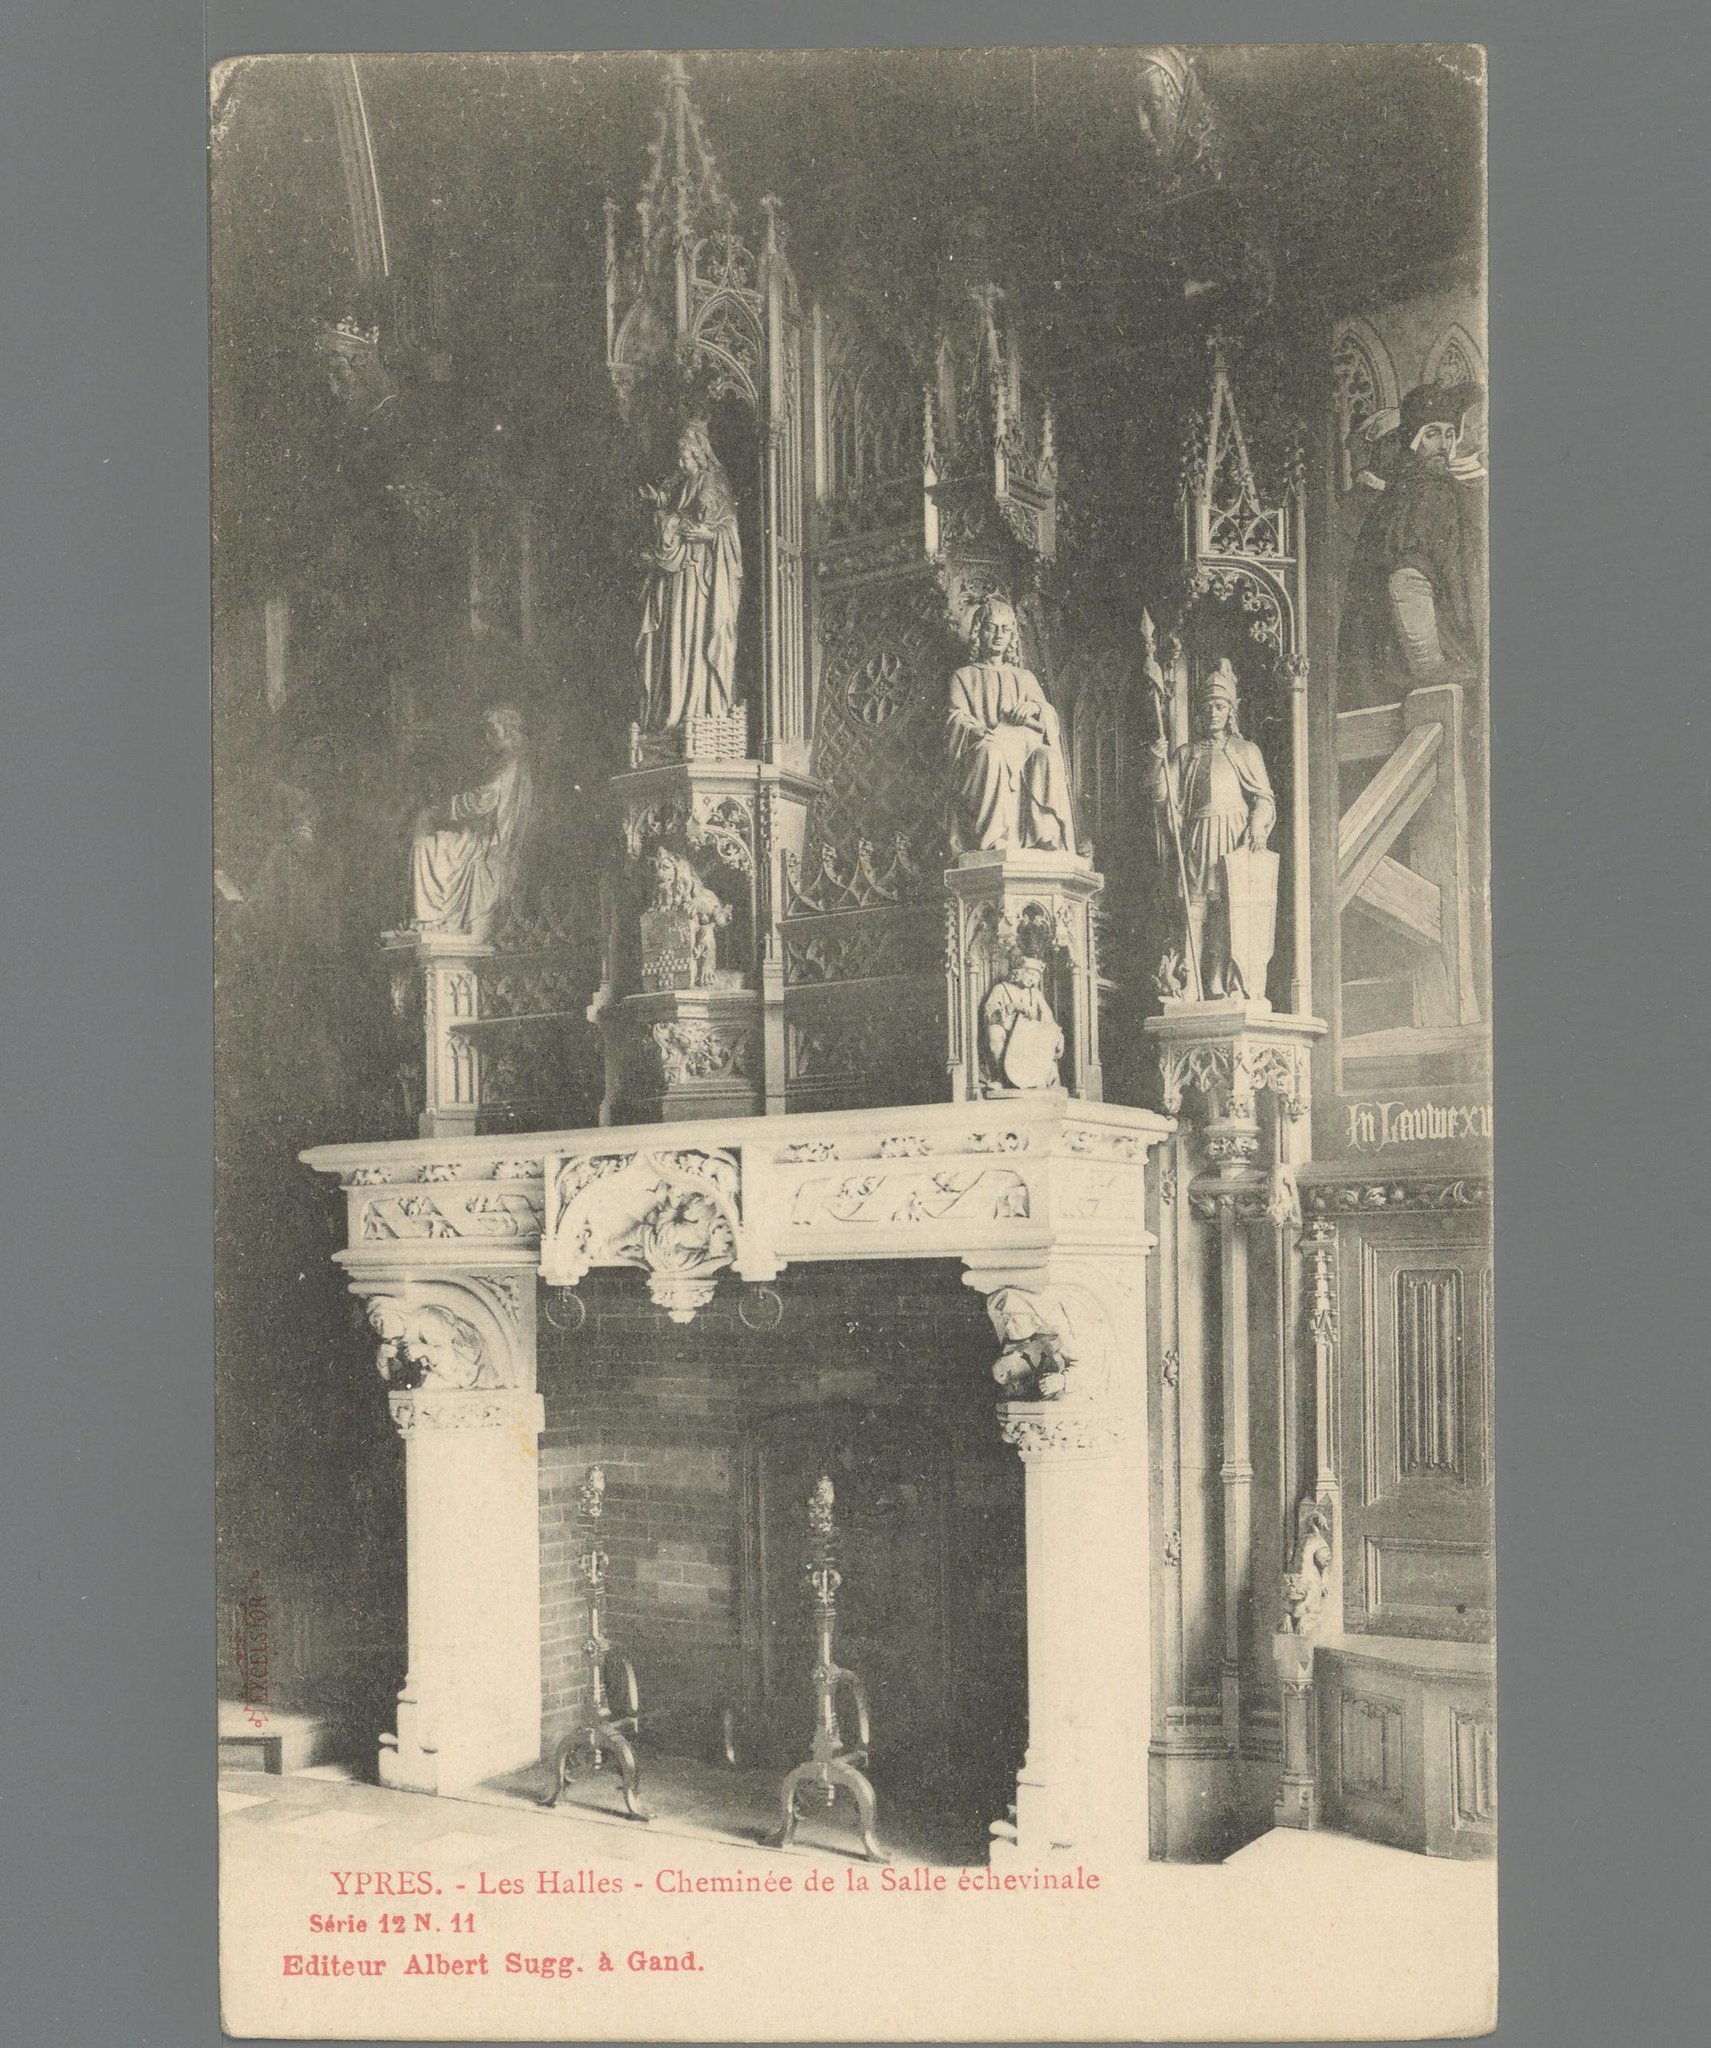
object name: ansichtkaart, prentbriefkaart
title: Ypres. Les Halles. Cheminée de la Salle échevinale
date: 1896-1906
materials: cardboard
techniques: photograph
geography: ghent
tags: chimney-piece, mantelpiece